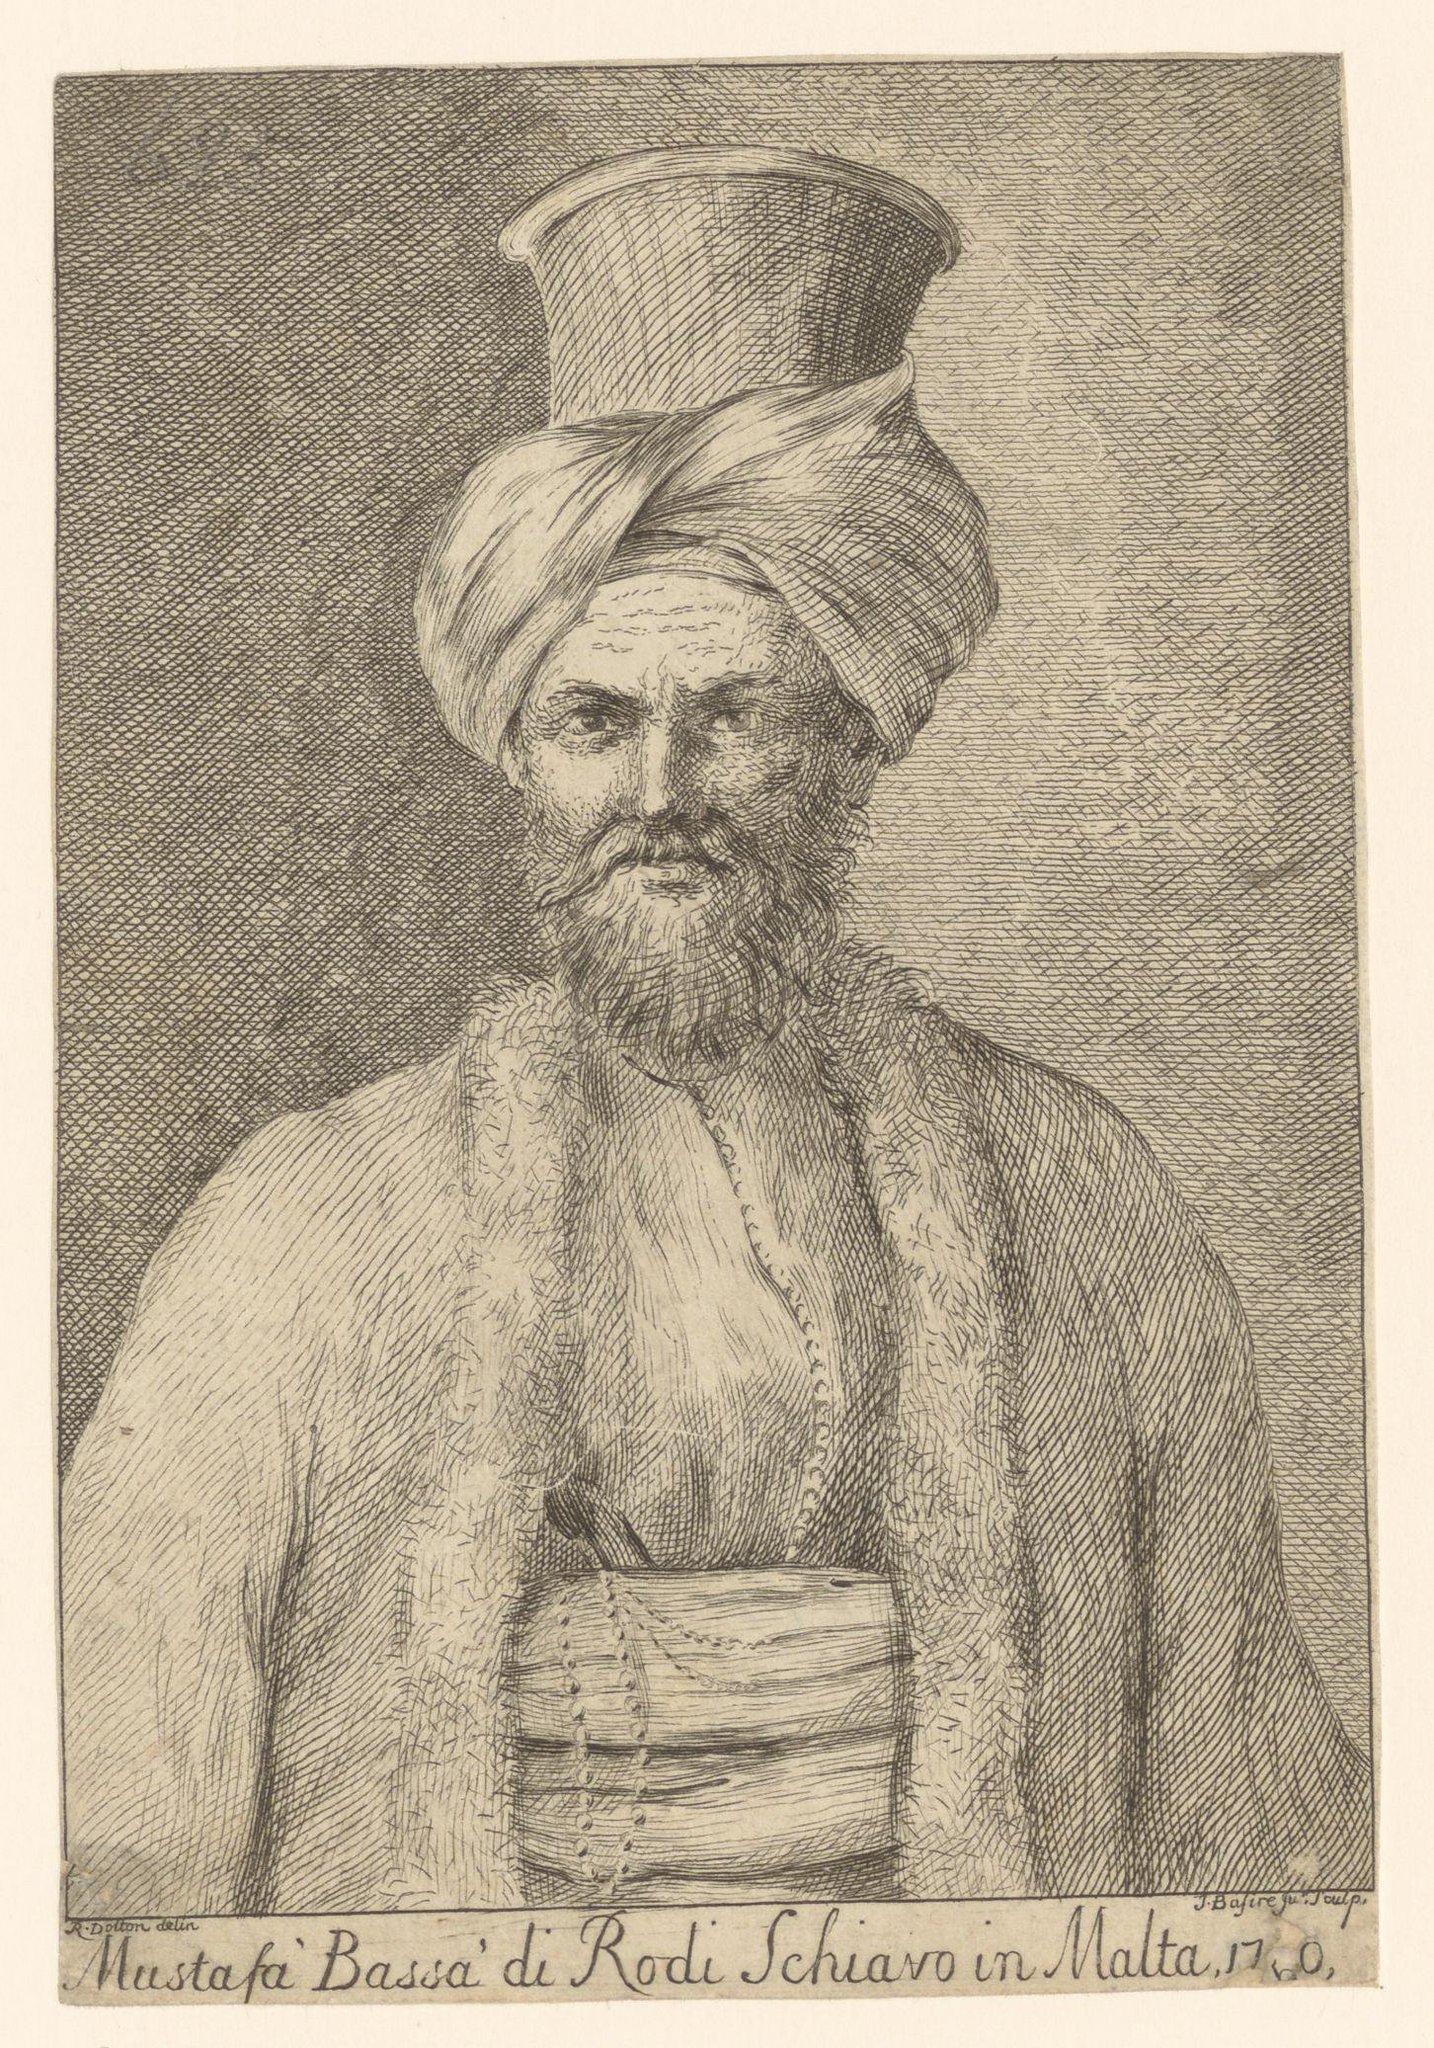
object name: print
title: Portret van Mustafa, Pasja van Rodos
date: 1750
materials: paper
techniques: etching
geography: london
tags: commander-in-chief, general, marshal, historical persons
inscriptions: collector's mark: Lugt 2228